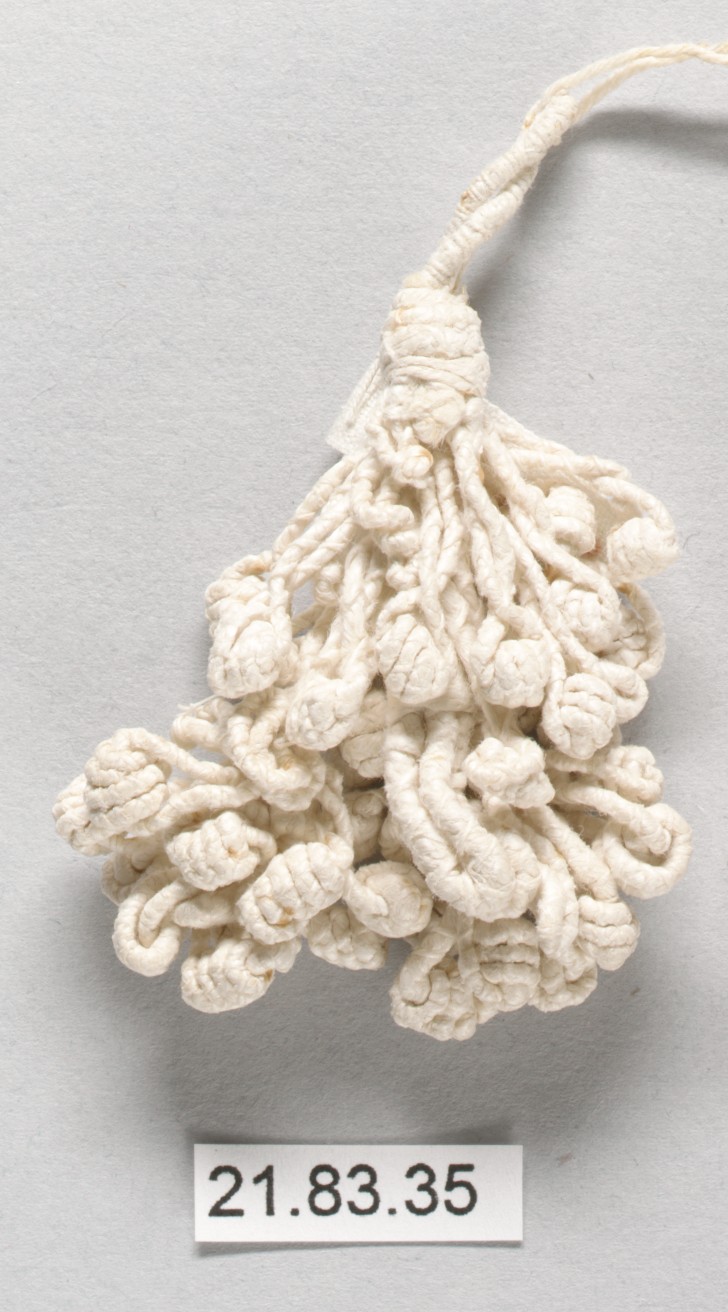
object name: tassel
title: Pair of tassels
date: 1601-1700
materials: linen